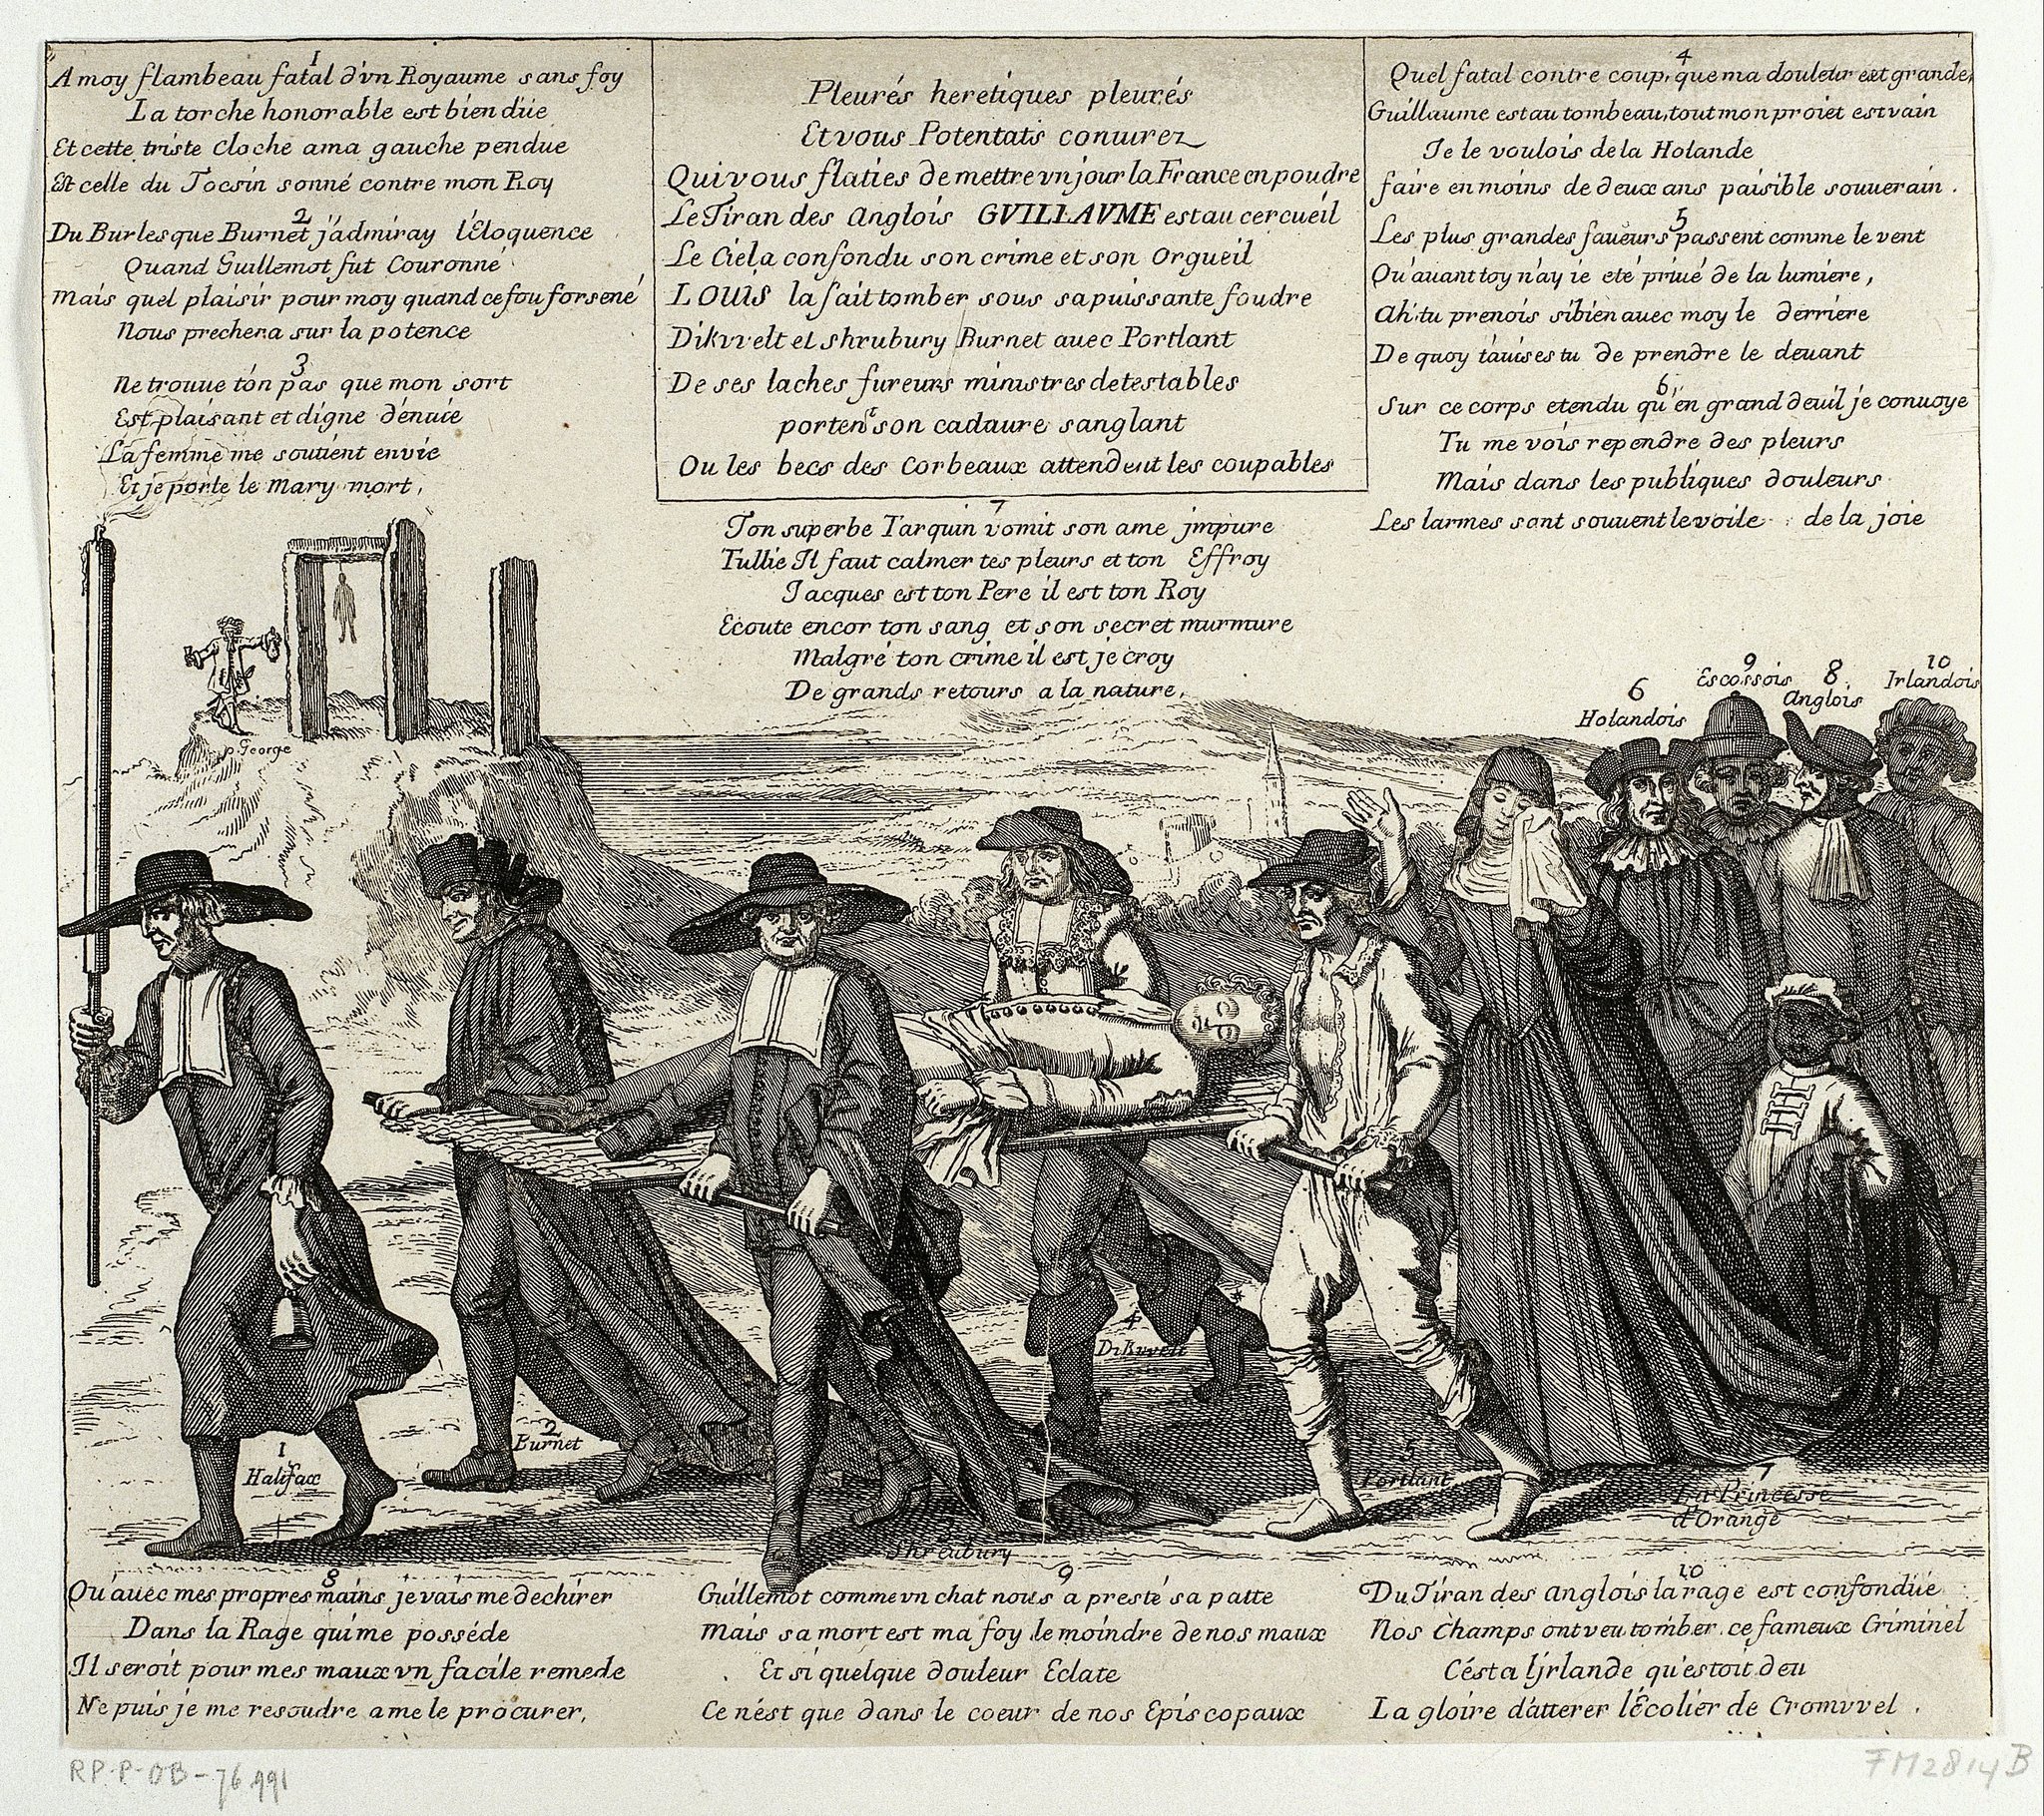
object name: cartoon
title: Franse spotprent op de vermeende dood van Willem III, 1690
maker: Anonymous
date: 1690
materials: paper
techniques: etching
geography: france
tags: the hague, william iii (prince of orange and king of england, scotland, and ireland), london, maria ii stuart (koningin van engeland, schotland en ierland), clergyman, cortege, funeral procession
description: Franse spotprent op de vermeende dood van Willem III tijdens de slag aan de Boyne op 11 juli 1690. Begrafenisstoet waarin het lichaam van de dode Willem III op een brancard wordt gedragen, voorop George Savile, eerste markies van Halifax, met een toorts, gevolgd door de dragers: bisschop Gilbert Burnet, Charles Talbot, twaalfde graaf van Shrewsbury, Everhard van Weede van Dijkvelt en de graaf van Portland. Achter de baar de prinses van Oranje, een Hollander, een Engelsman, een Schot en een Ier. Linksachter een galg. In de plaat opschriften bij de personen genummerd 1-10 in het Frans.